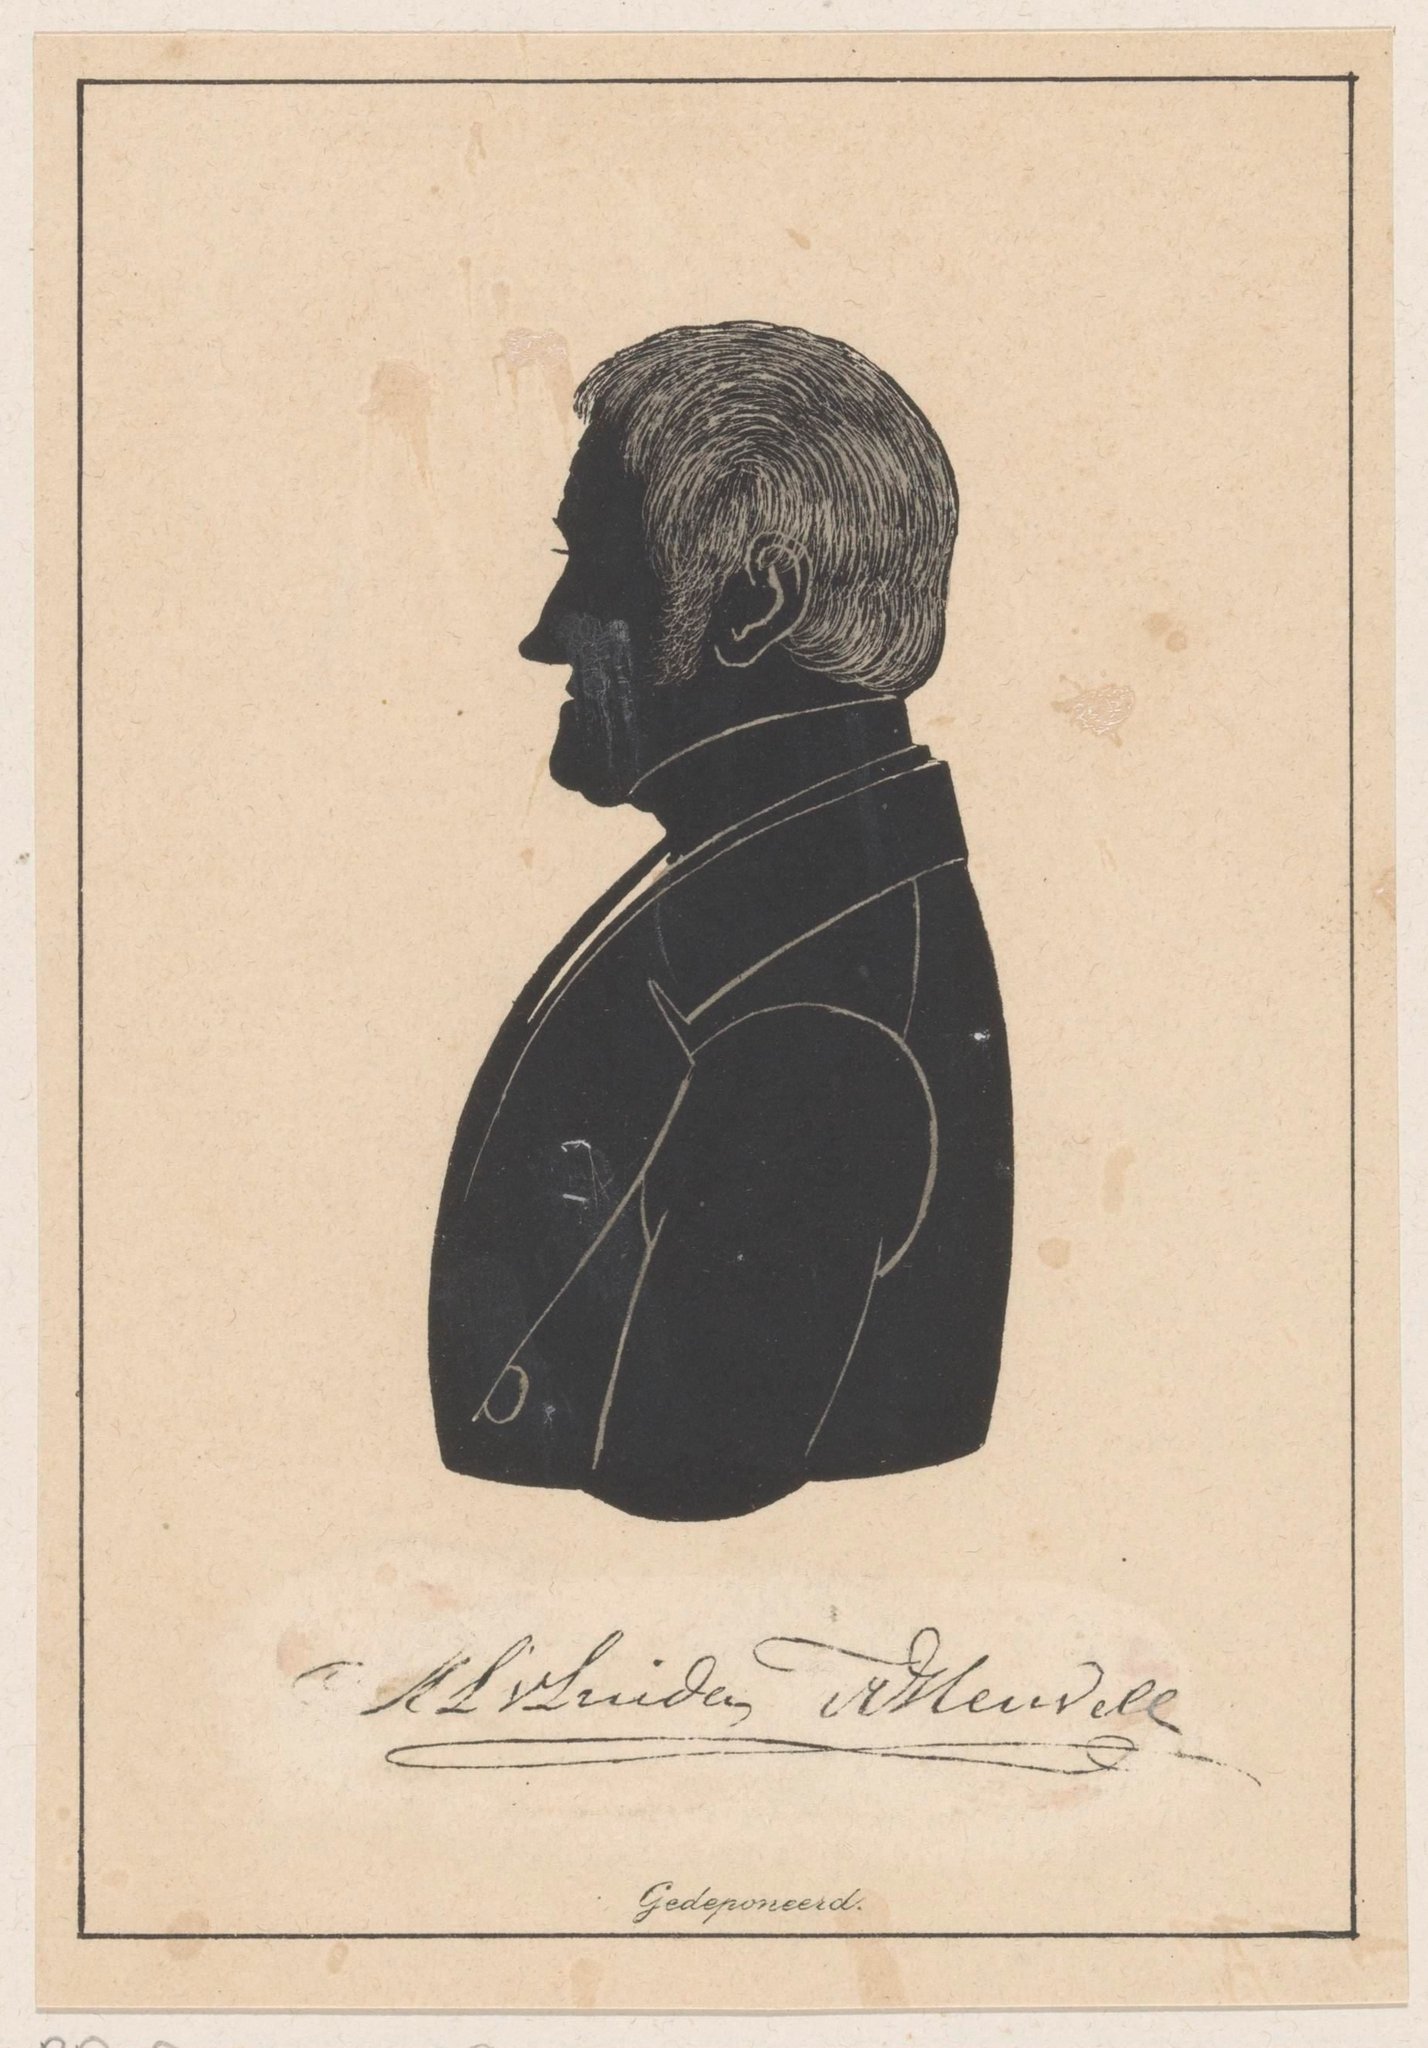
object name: print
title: Silhouetportret van Hendrik Luidwijn van Linden van den Heuvell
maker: pieter barbiers (iv)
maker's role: painter, print maker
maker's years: 1798-1848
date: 1809-1848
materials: paper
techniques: hand coloring, lithograph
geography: netherlands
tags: the hague, hendrik luidwijn van linden van den heuvell, historical persons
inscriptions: collector's mark: Lugt 2228, : ‘Gedeponeerd.’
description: Onder het portret de signatuur van de geportretteerde.